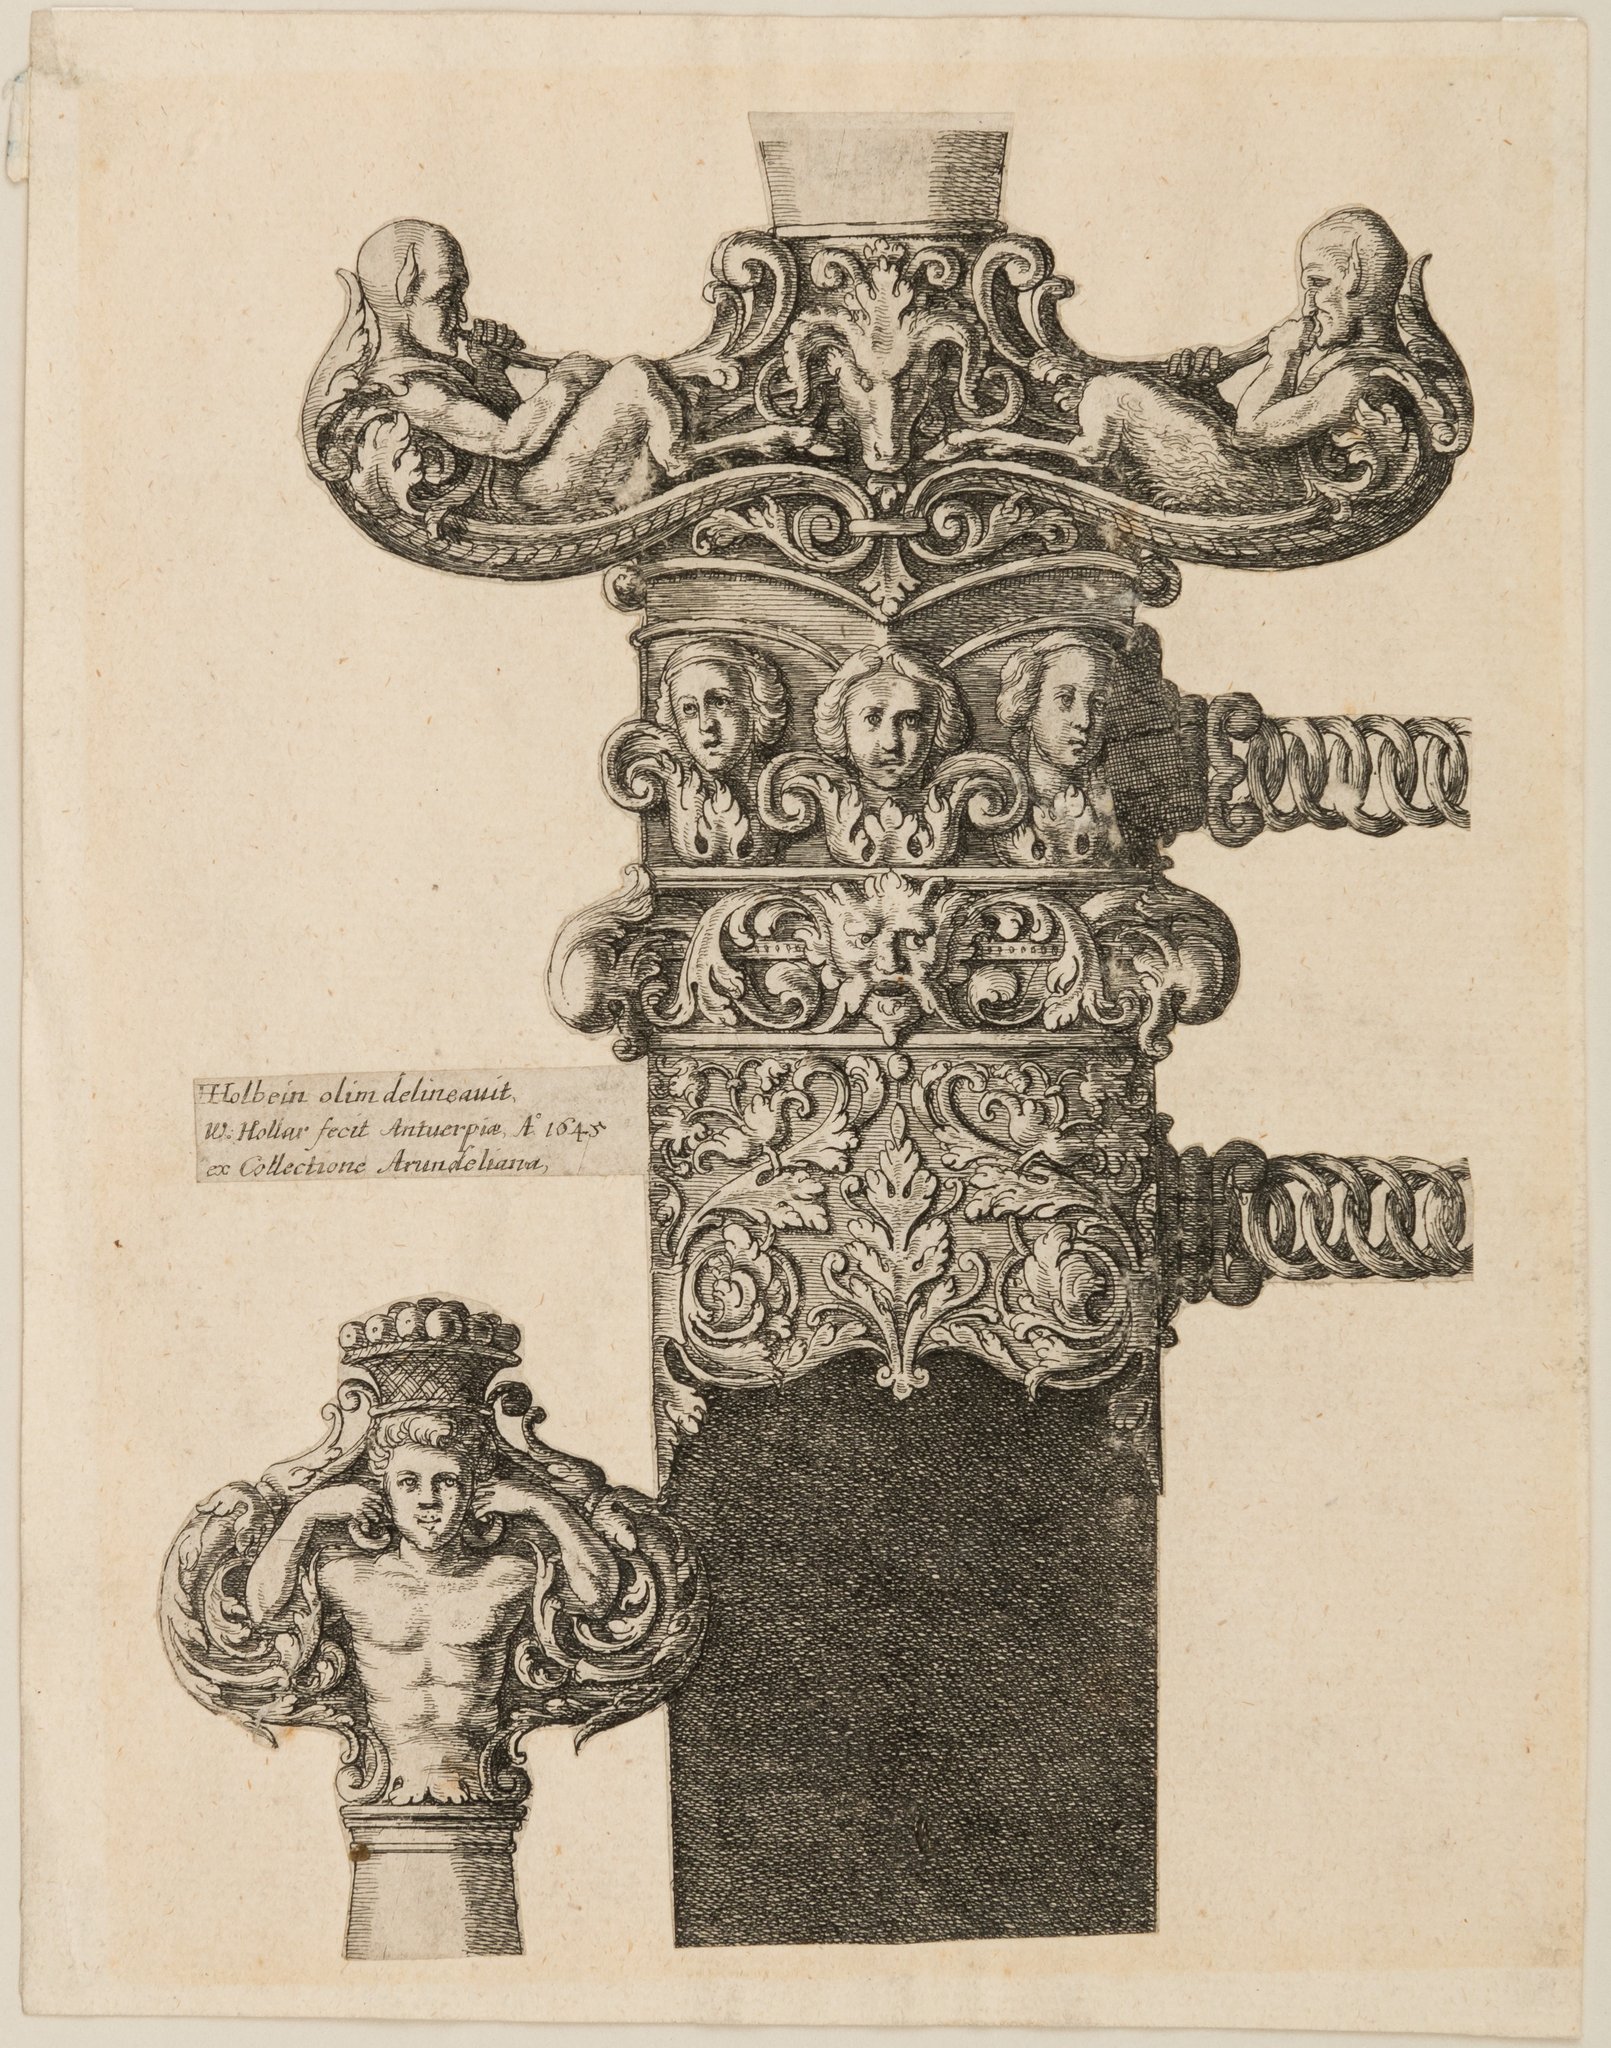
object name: print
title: Print of Designs for a Pommel, Quillons, and Locket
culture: british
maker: hans holbein the younger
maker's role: designer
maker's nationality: german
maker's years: 1497-1543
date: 1645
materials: ink, paper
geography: england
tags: ornament